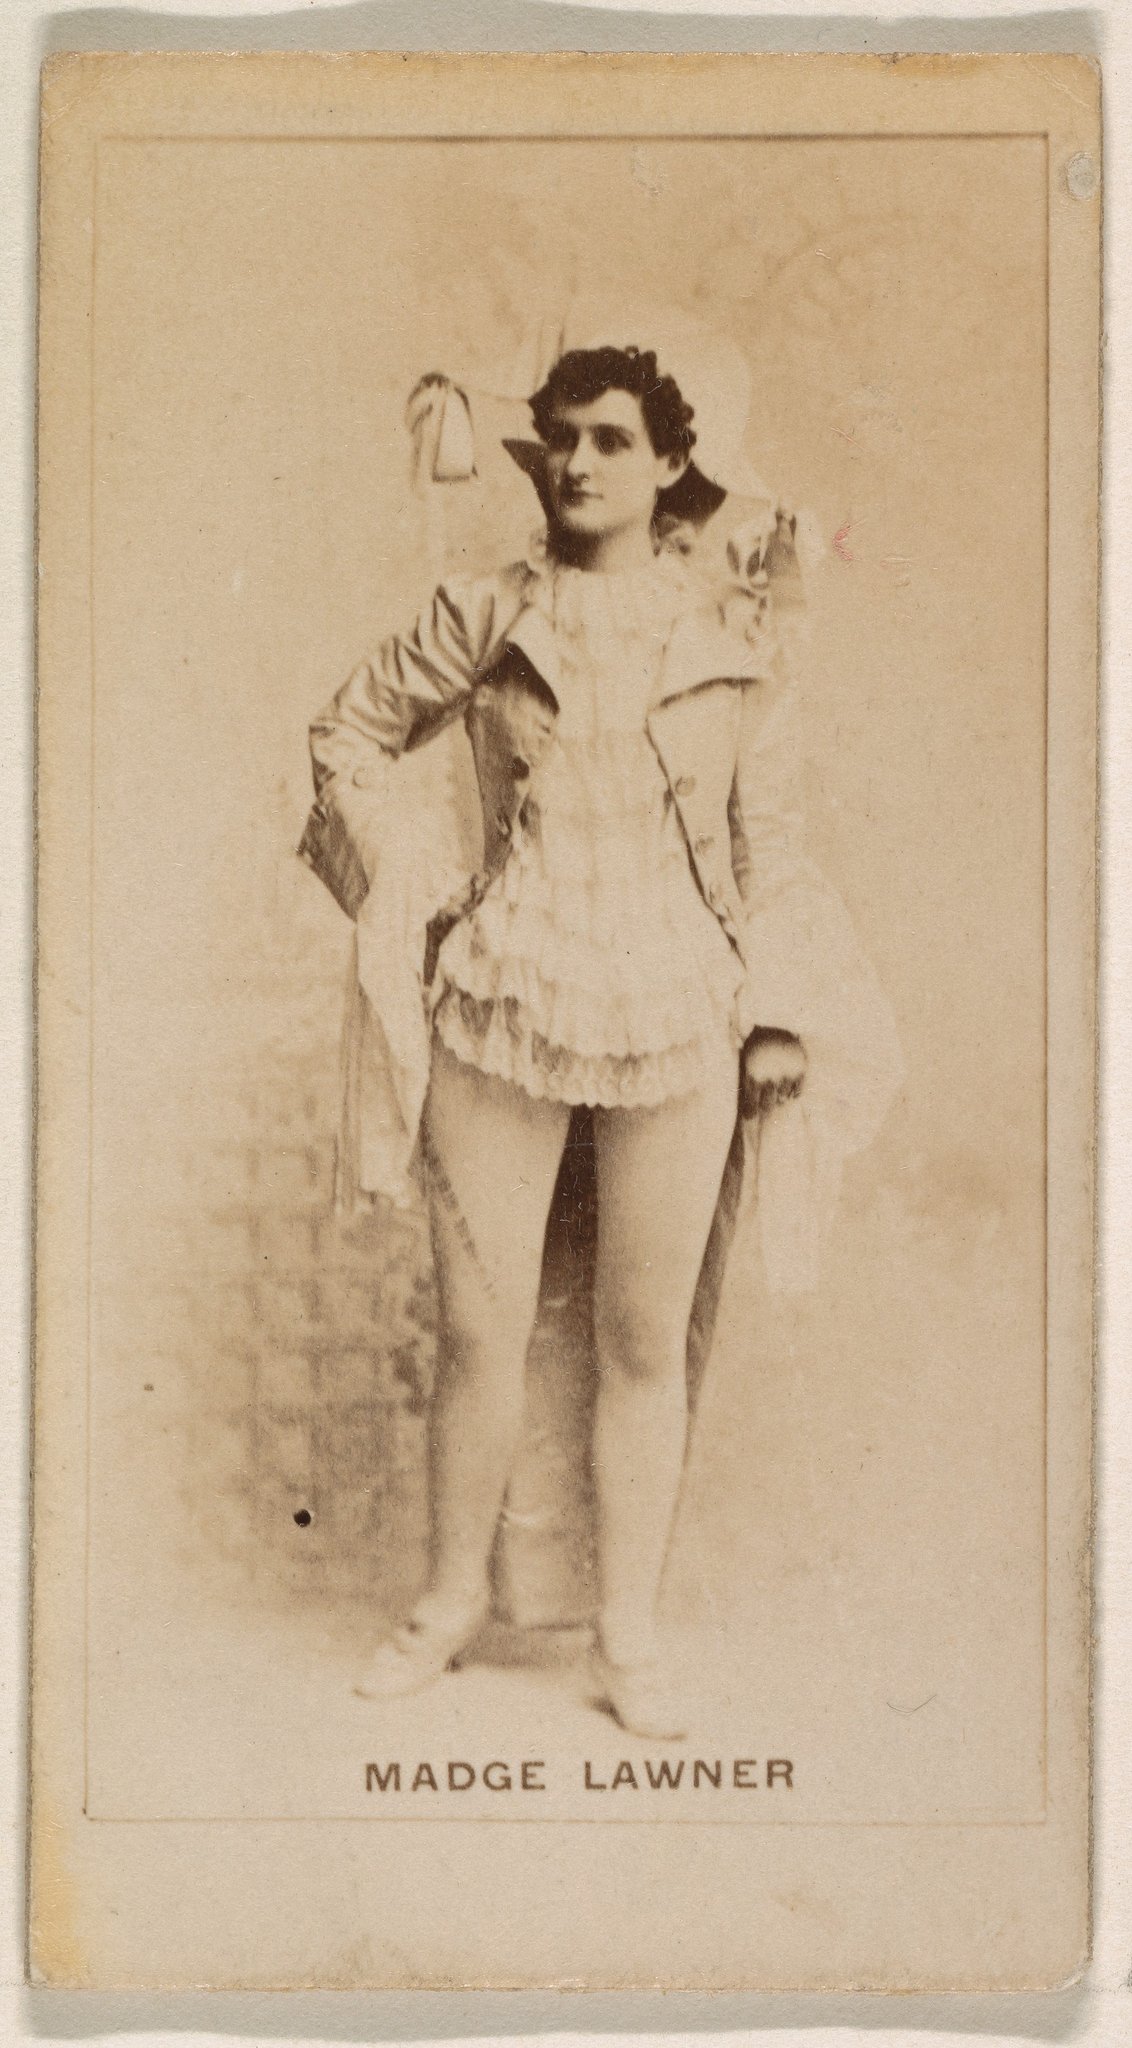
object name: photograph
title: Madge Lawner, from the Actresses series (N245) issued by Kinney Brothers to promote Sweet Caporal Cigarettes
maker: kinney brothers tobacco company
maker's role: publisher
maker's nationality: american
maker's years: 1869-2011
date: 1890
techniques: albumen silver print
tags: portraits,women,actresses